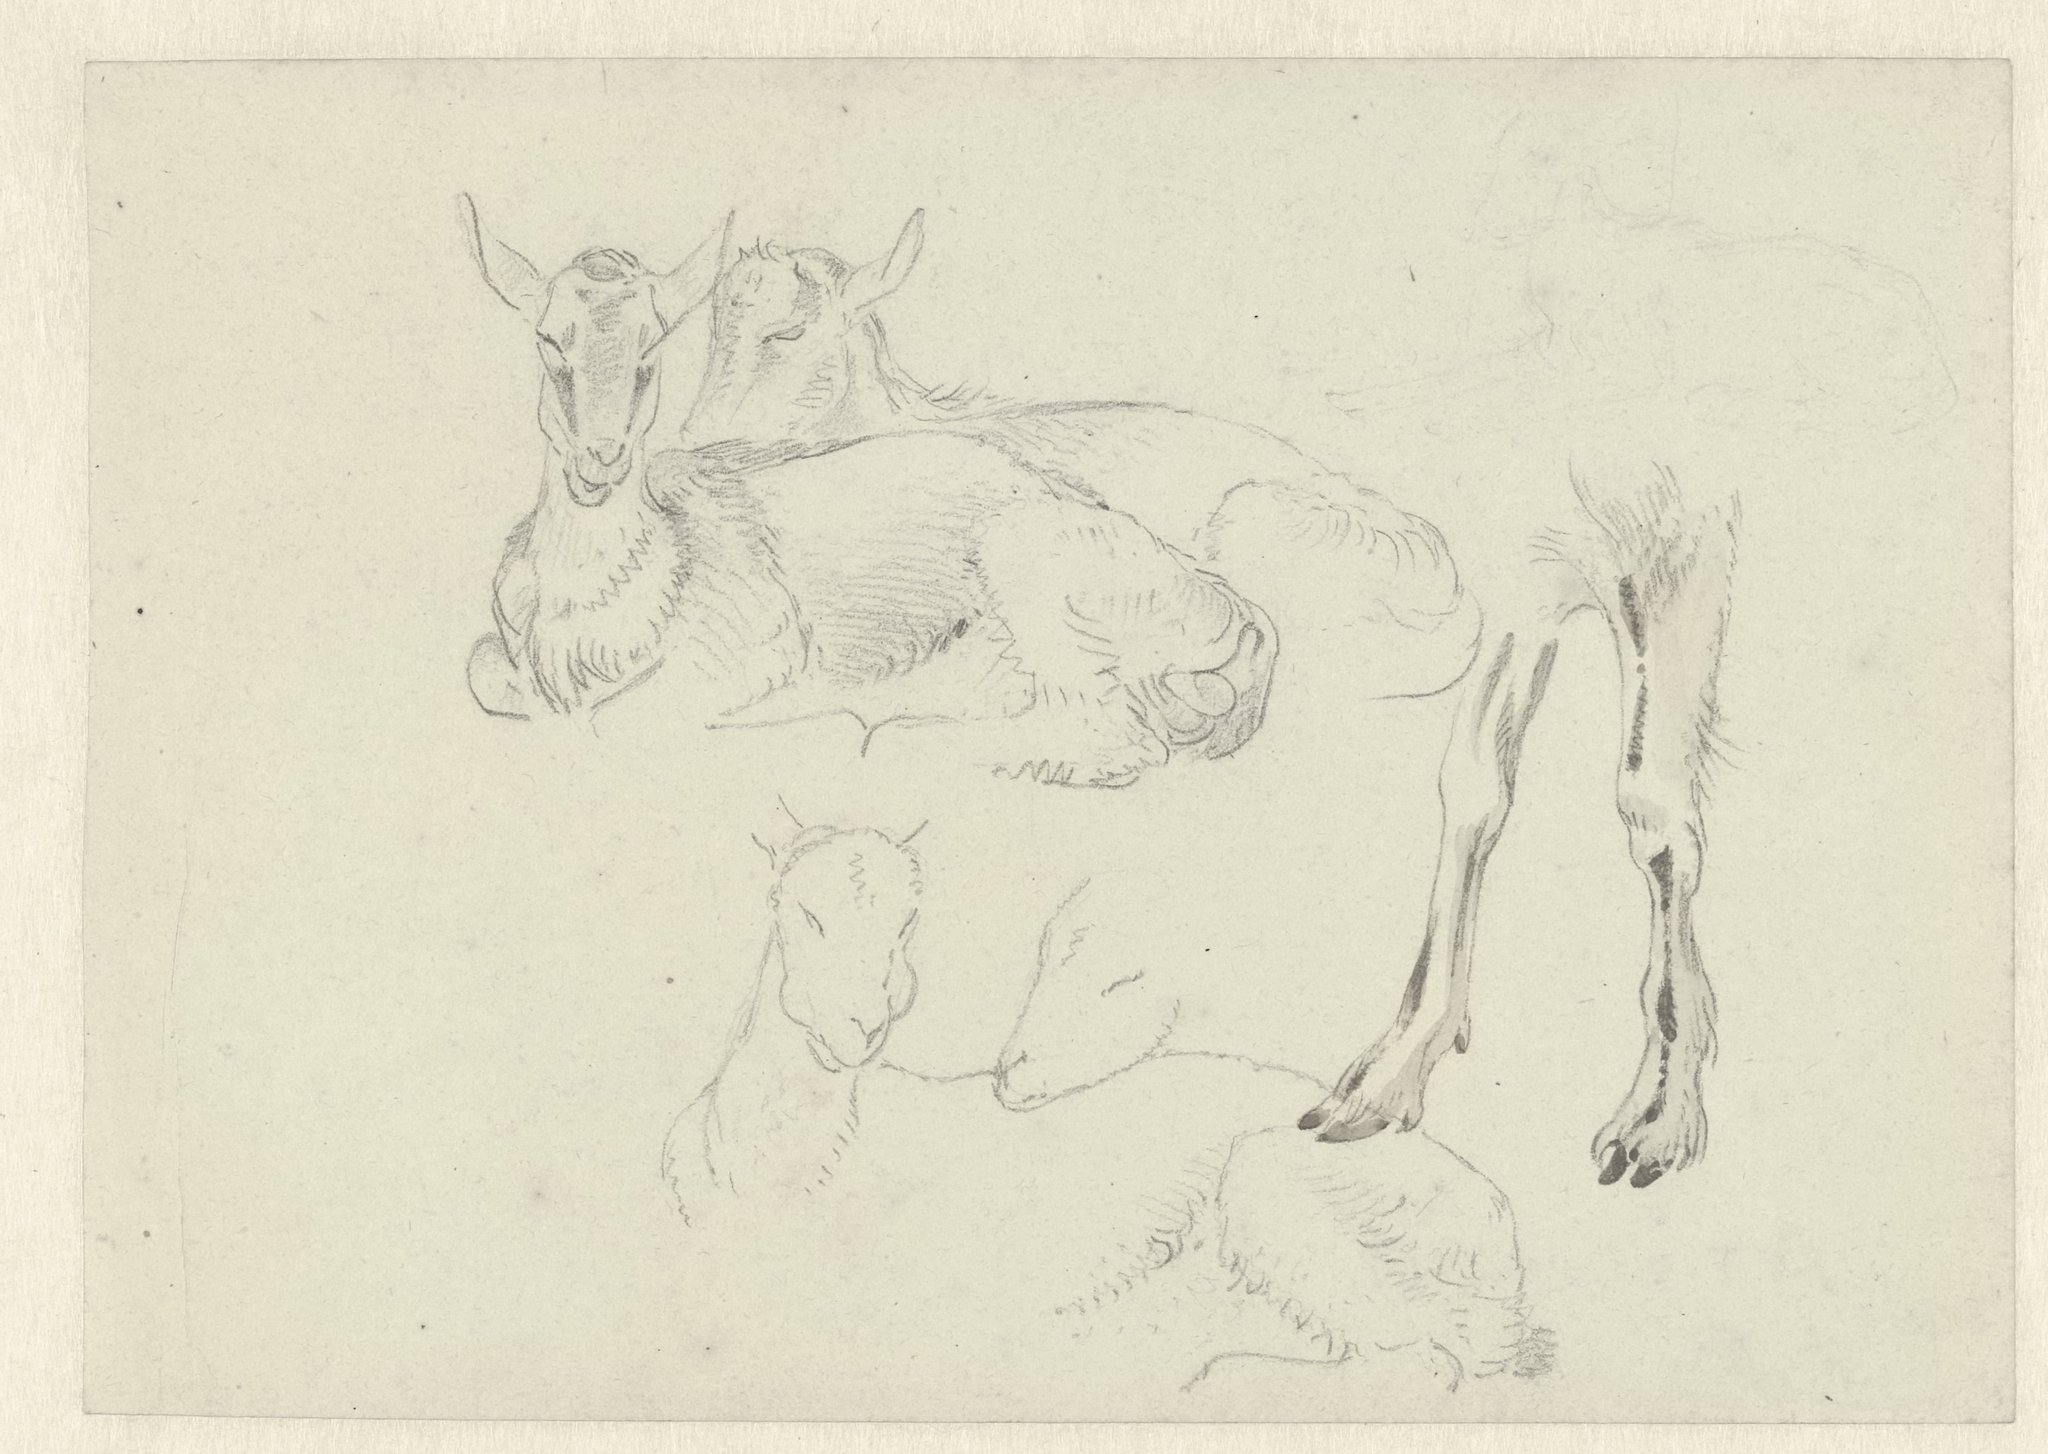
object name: drawing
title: Studies of Goats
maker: josephus augustus knip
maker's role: draughtsman, painter, print maker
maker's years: 1777-1847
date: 1809-1812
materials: graphite, paper, watercolor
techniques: brush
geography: italy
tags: goat, italy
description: Knip must have drawn these kinds of small studies of animals in large numbers. They proved useful as staffage in his painted landscapes populated with ‘beeldjes en beestjes’ (figures and beasts), as they were described in the 19th century.